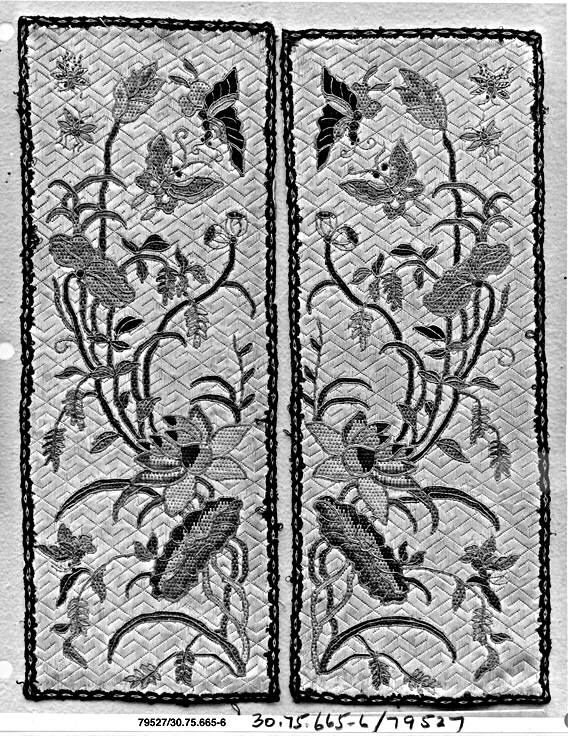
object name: panel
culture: chinese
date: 1644-1911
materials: silk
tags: flowers,plants